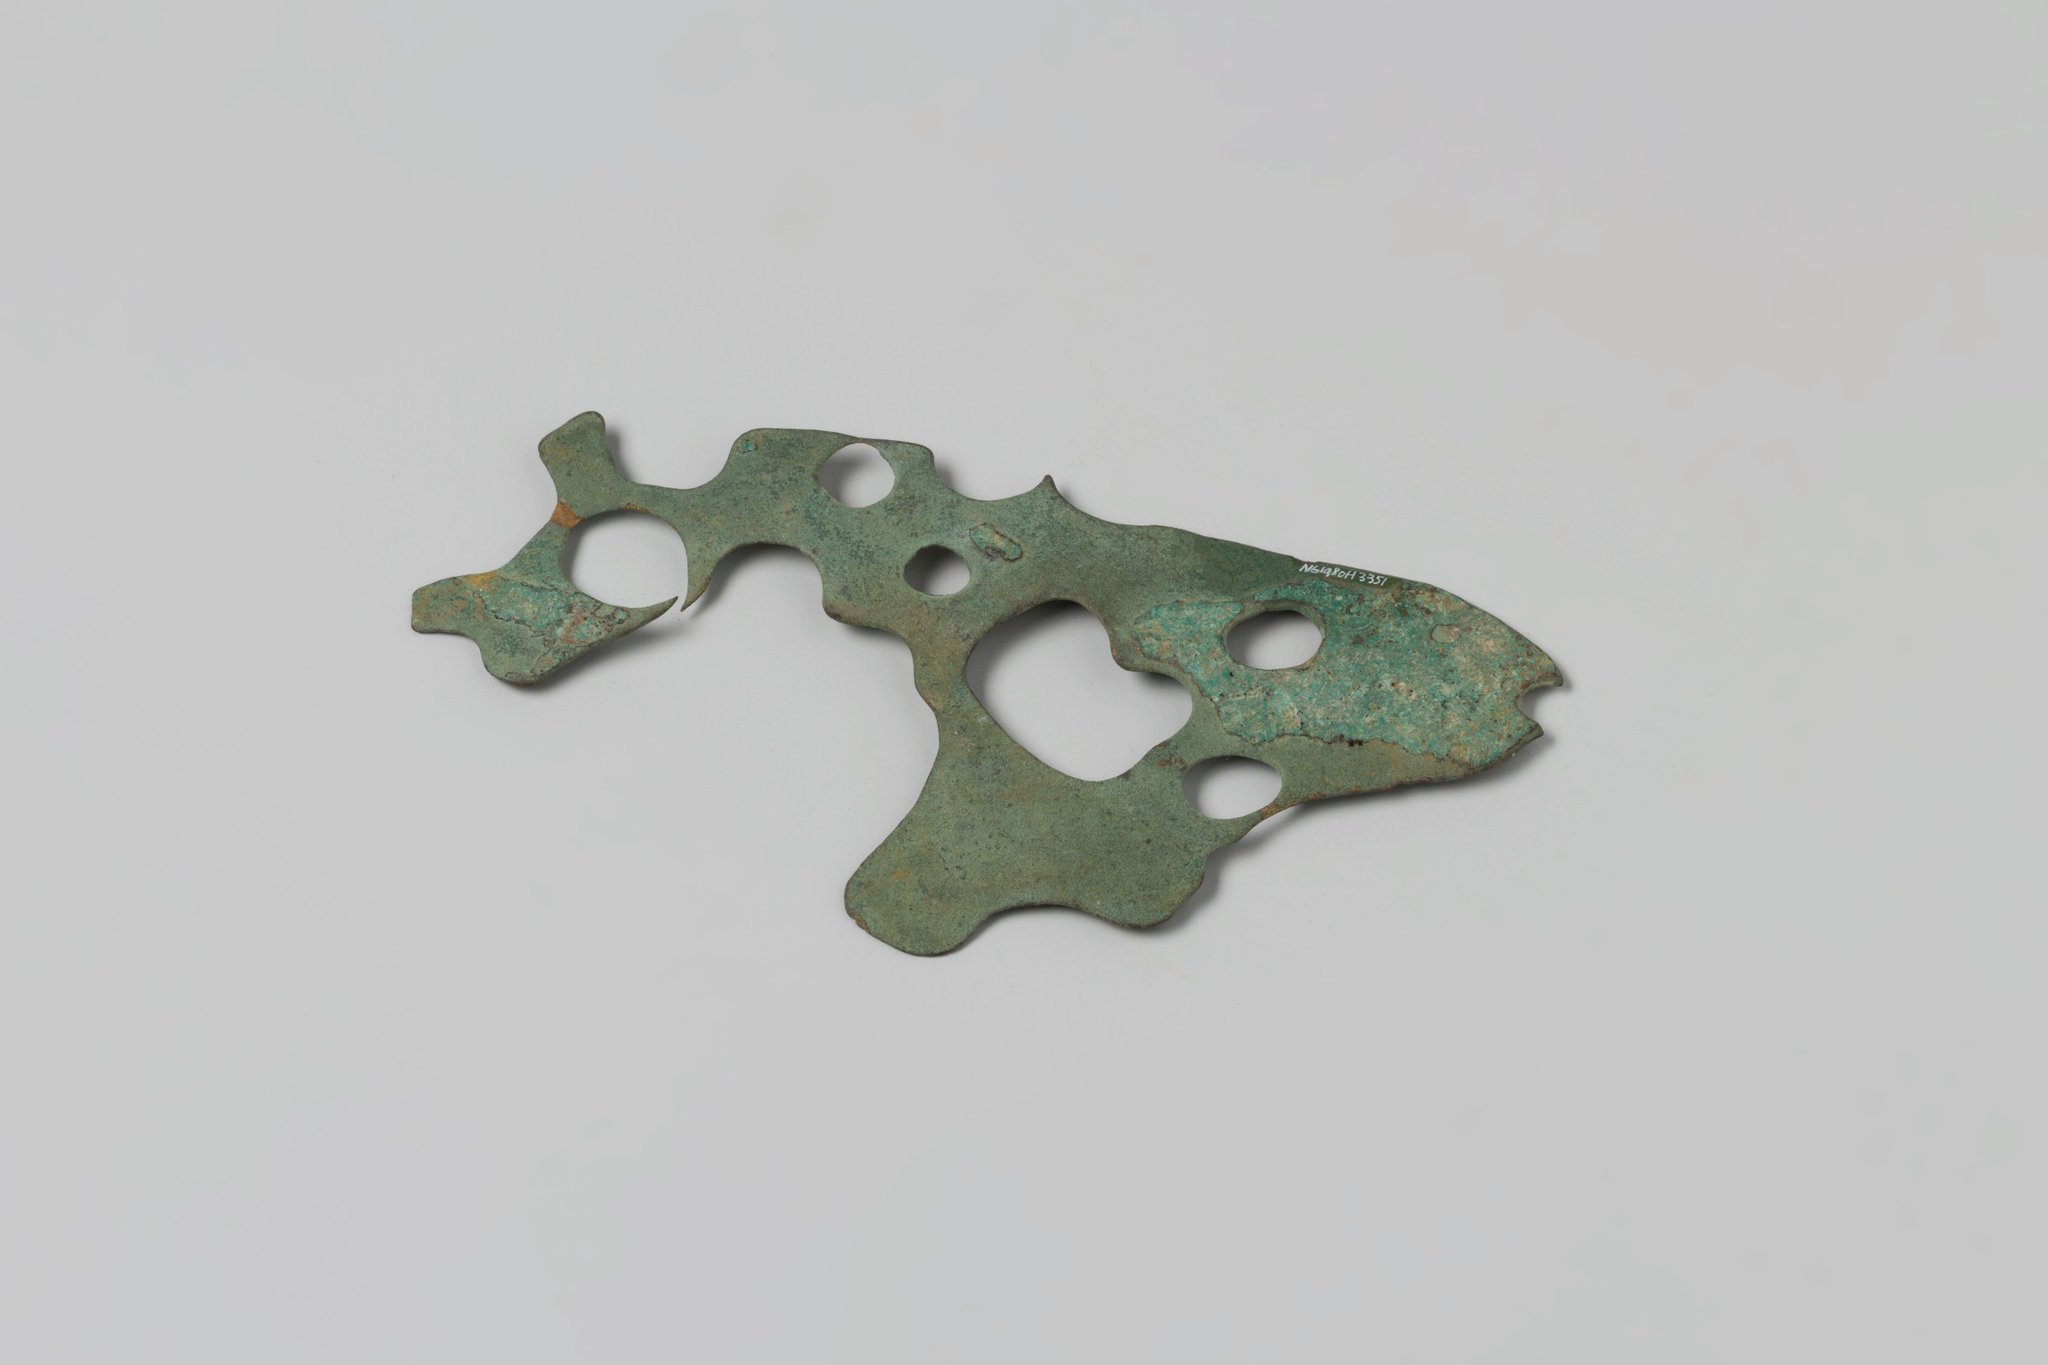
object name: fragment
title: Fragment plaatwerk uit het wrak van de Oost-Indiëvaarder Hollandia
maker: Anonymous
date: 1700-1743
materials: copper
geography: netherlands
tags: verenigde oostindische compagnie, hollandia (schip), annet